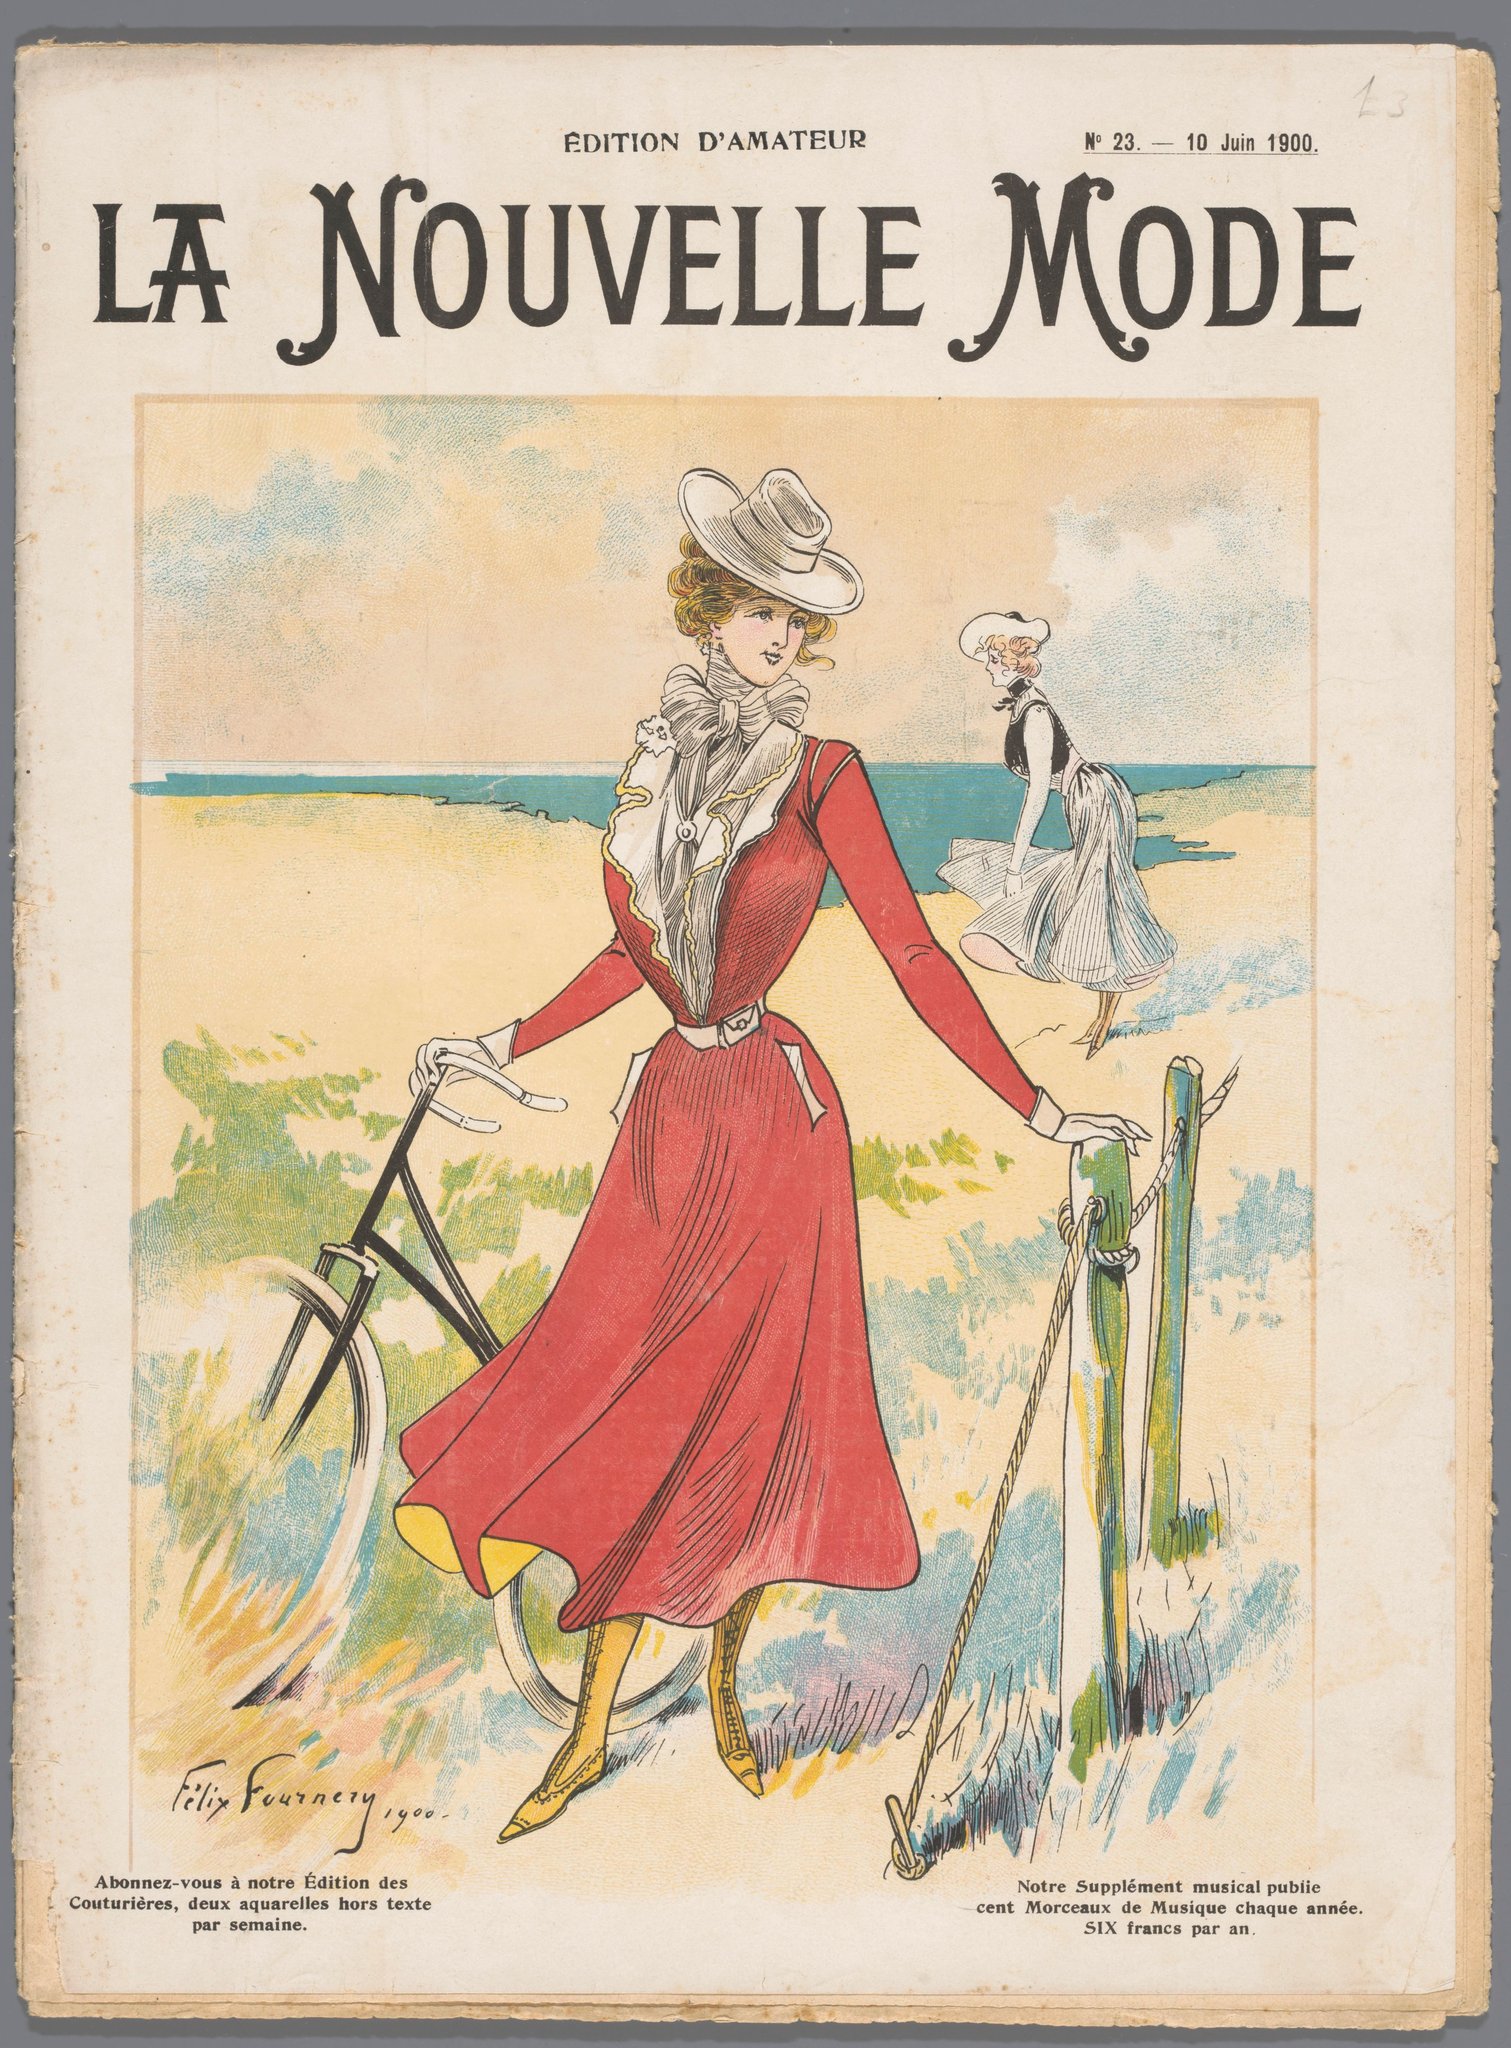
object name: fashion print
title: The Fashion Magazine as Temptress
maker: Anonymous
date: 1900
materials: paper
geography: paris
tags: fashion plates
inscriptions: title: ‘La Nouvelle Mode’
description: The first fashion magazines were sold only by subscription. They have nondescript covers, with neither text nor image. This changed at the end of the 19th century when the publications came to be displayed in stands and shops. Publishers went to great lengths to entice potential buyers by means of attractive covers.